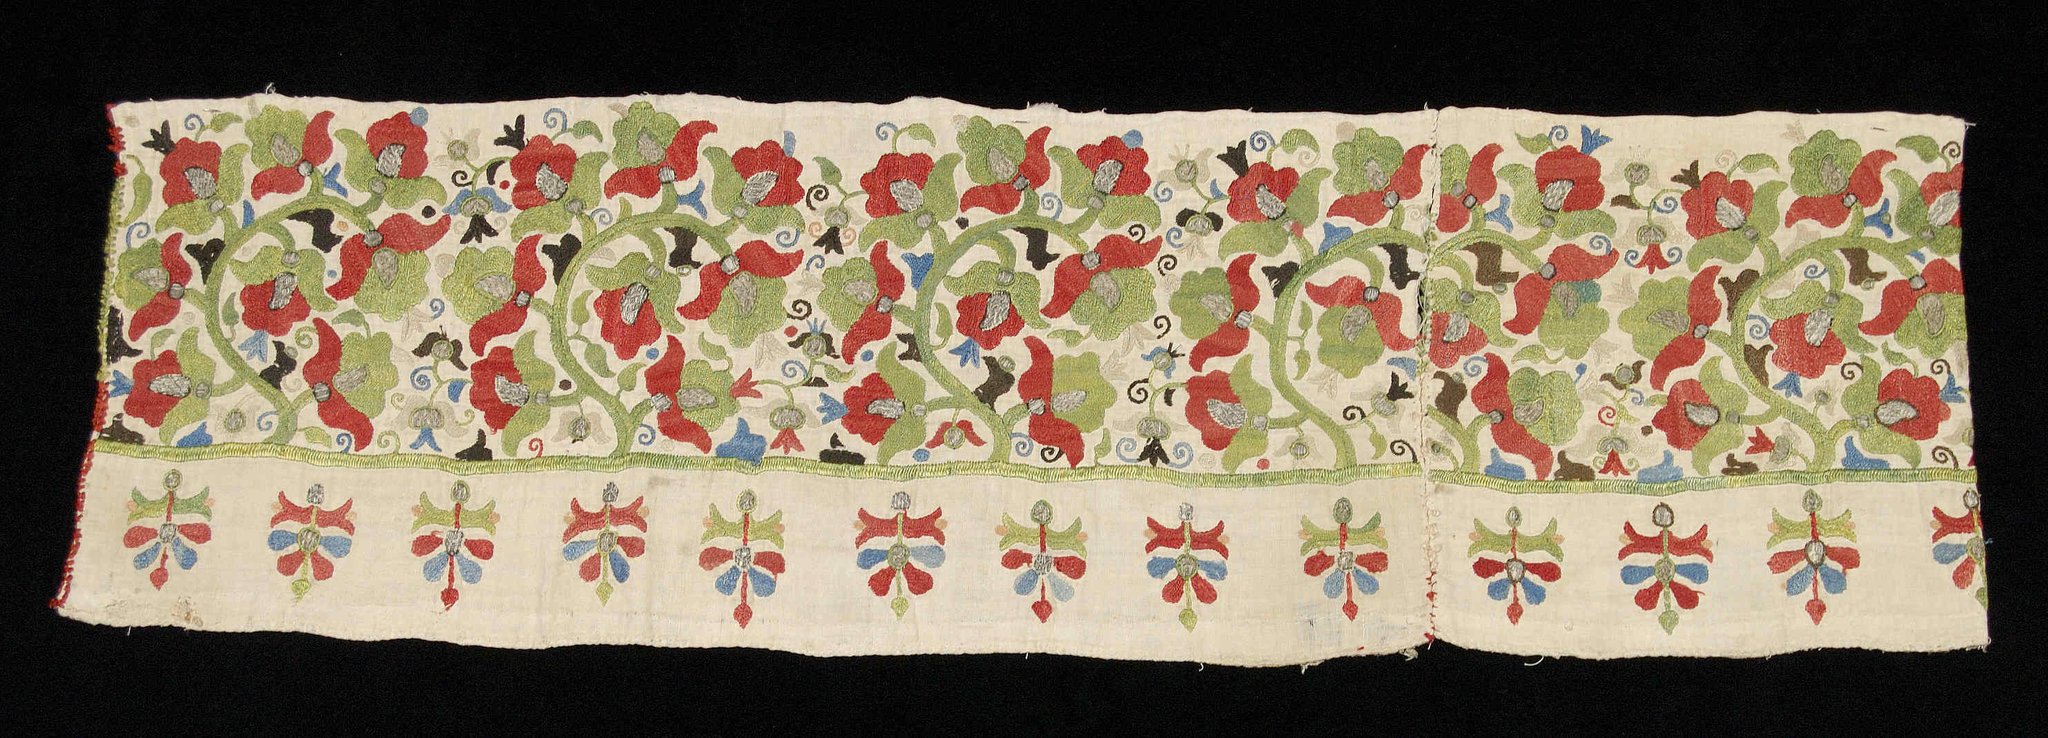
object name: textile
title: Fragment of a shirt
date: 1776-1800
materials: linen, silk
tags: flowers,leaves